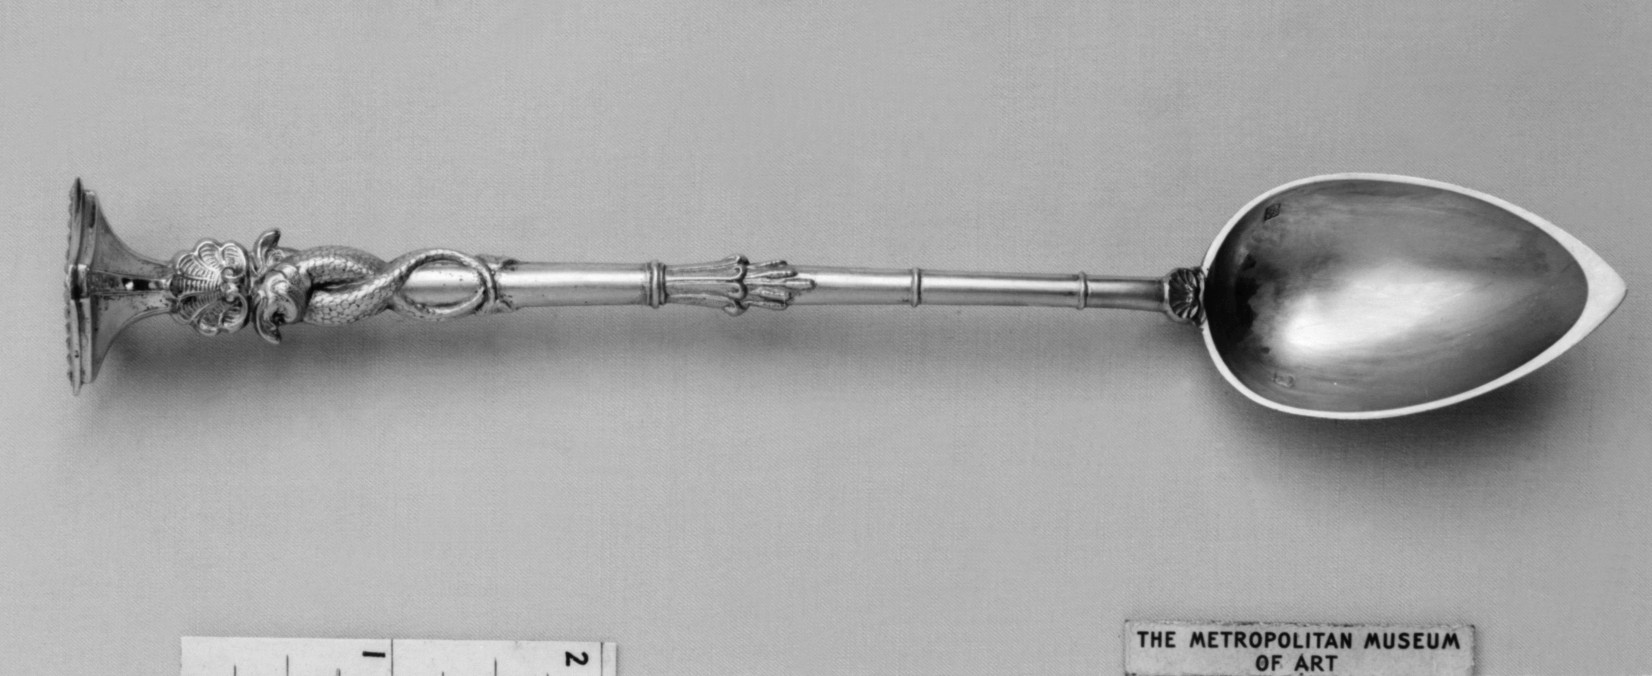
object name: spoon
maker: hippolyte thomas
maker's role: maker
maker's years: 1845-1855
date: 1834-1866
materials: silver gilt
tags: dolphins